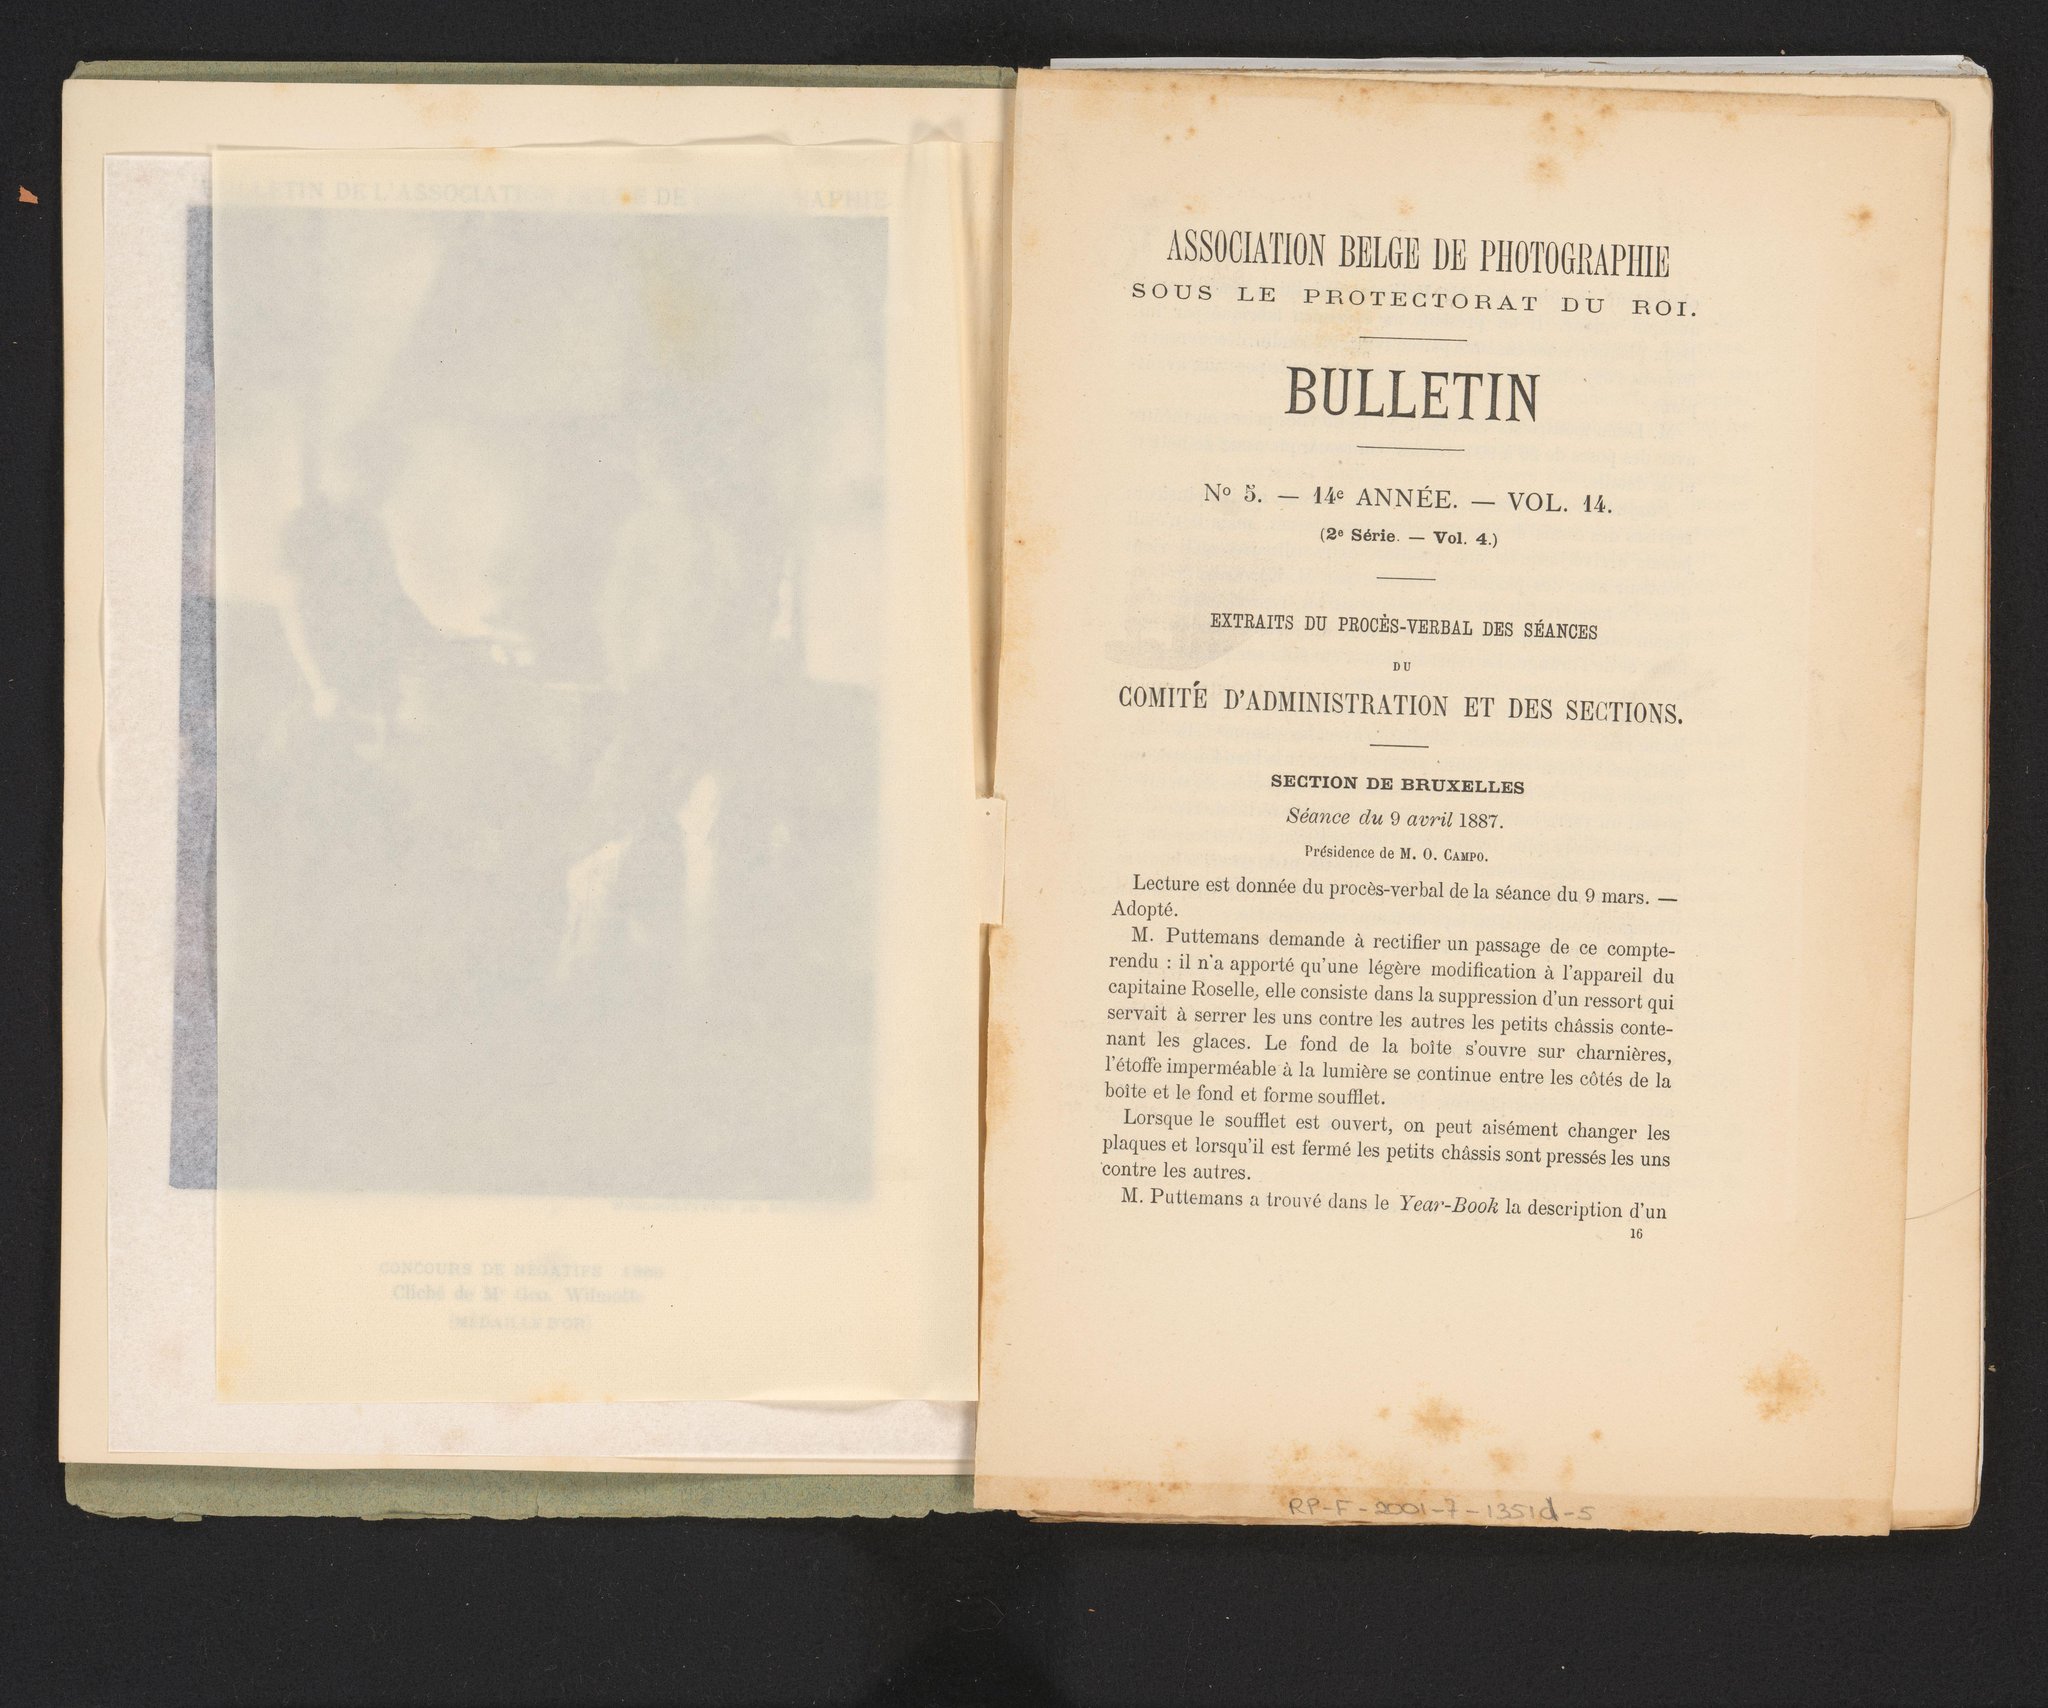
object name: book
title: Bulletin / Association belge de photographie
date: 1805-1887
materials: paper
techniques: printing, engraving, woodburytype